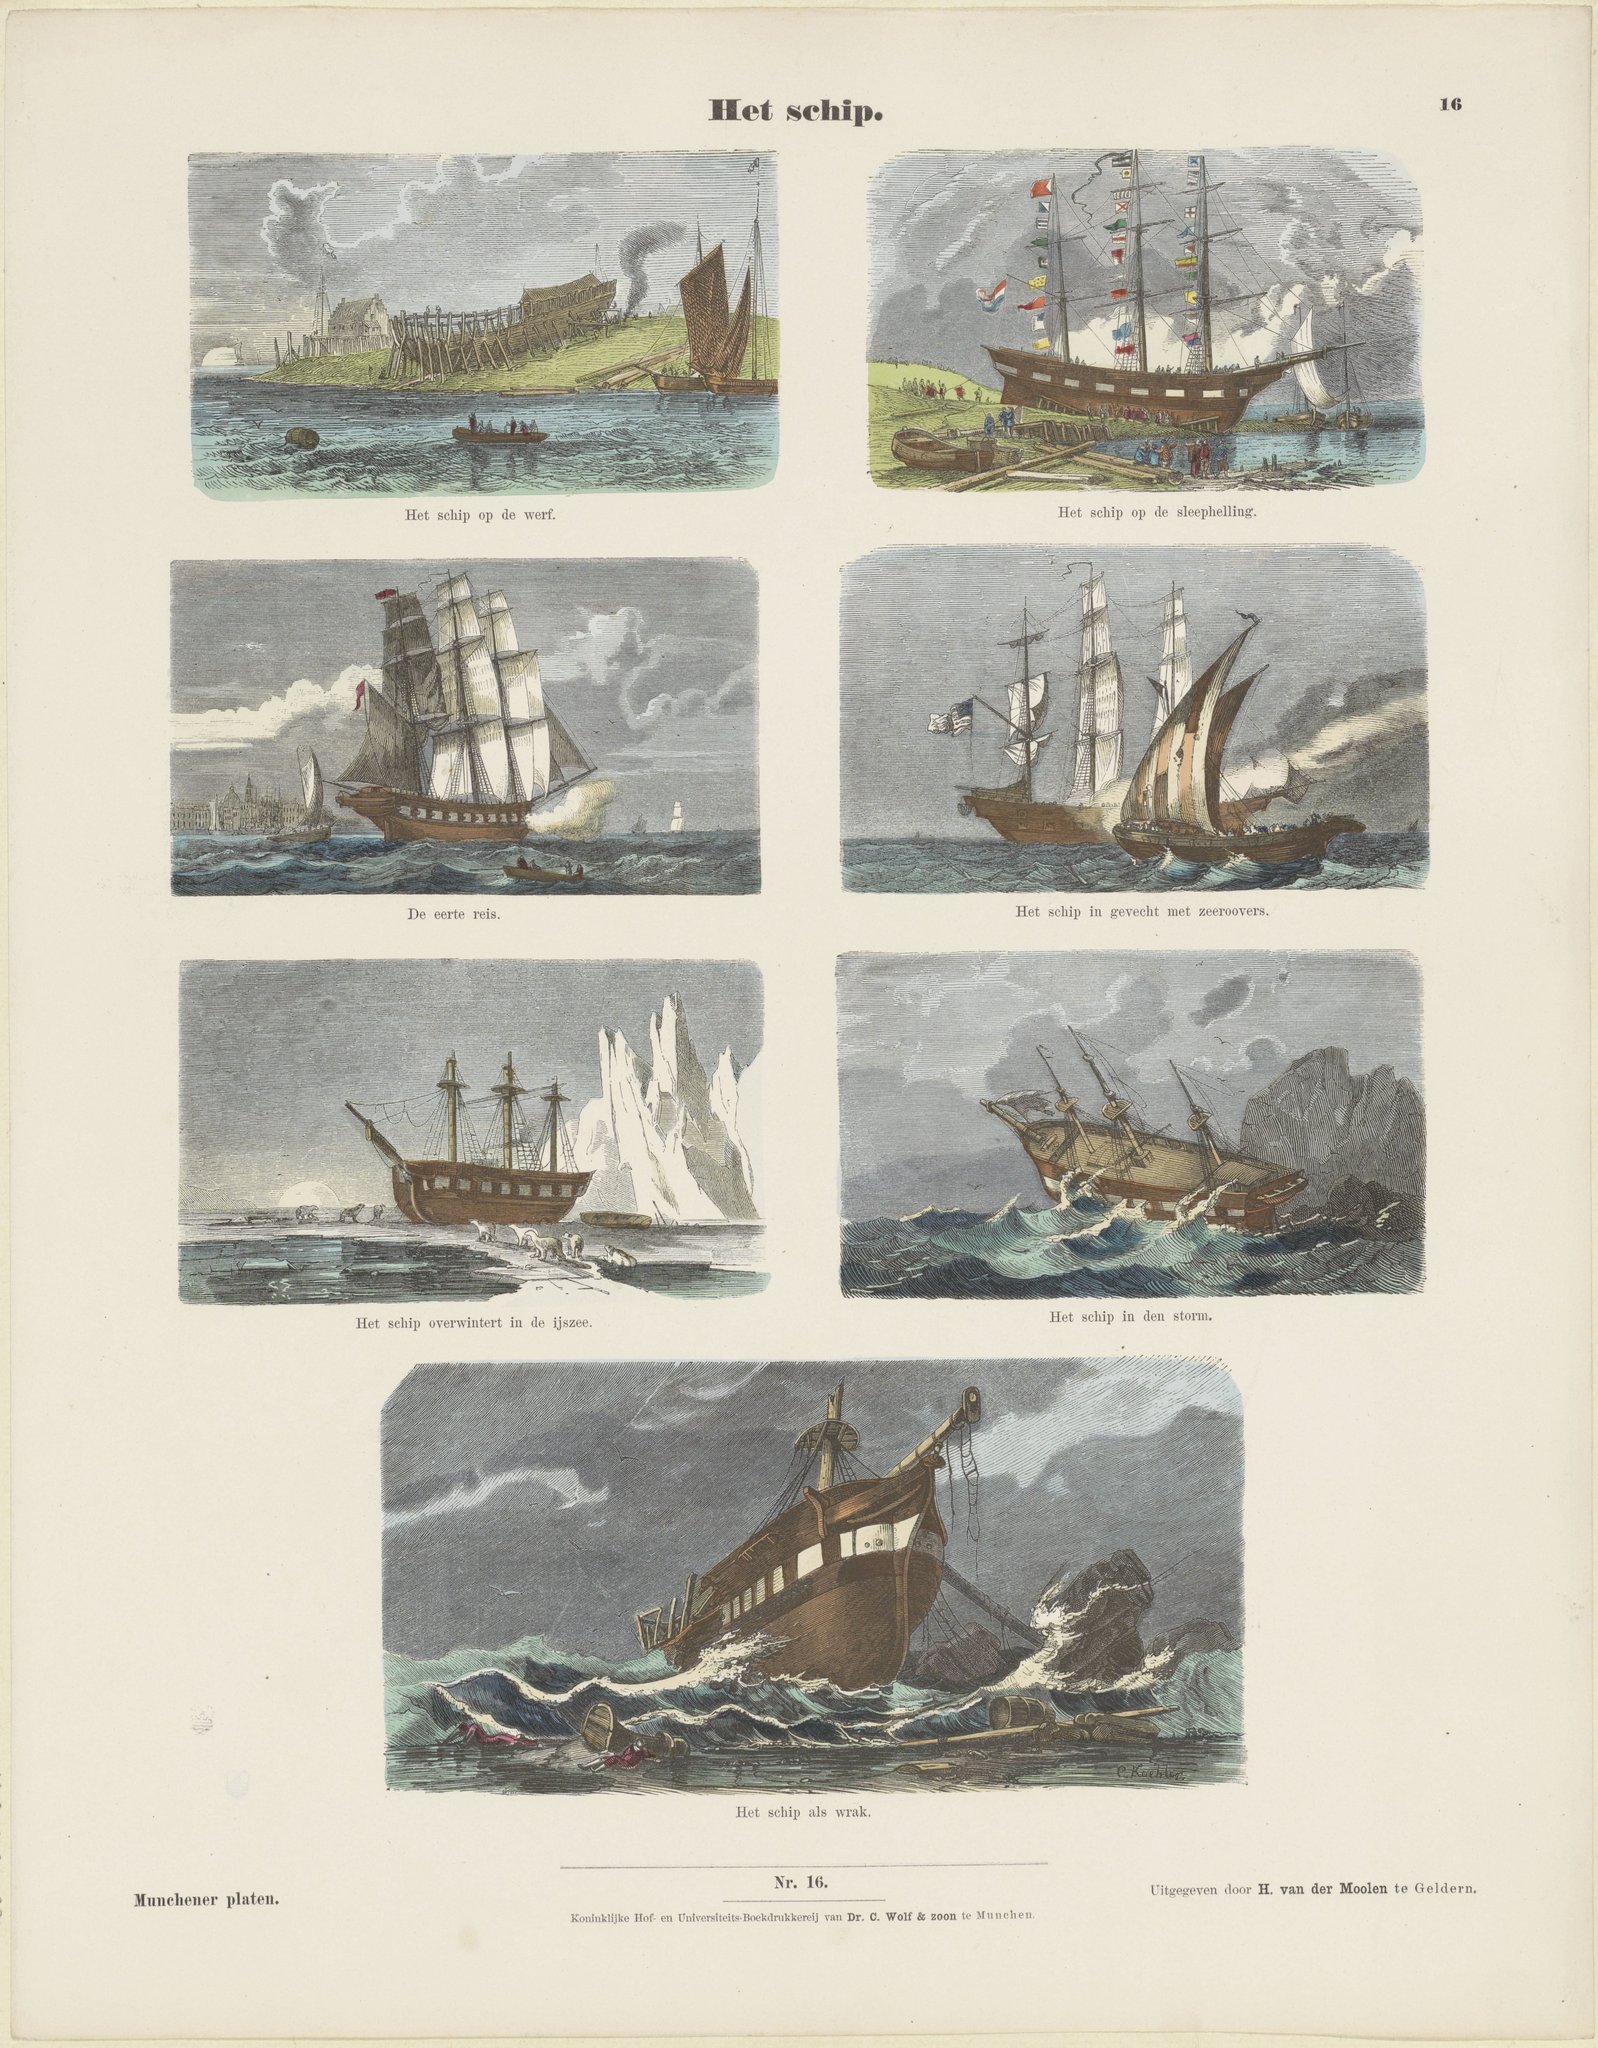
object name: print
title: Munchener platen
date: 1843-1920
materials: paper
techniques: colour, letterpress printing, engraving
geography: germany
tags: ships (in general)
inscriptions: collector's mark: Lugt 2760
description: Blad met 7 voorstellingen van schepen in verschillende situaties, waaronder op de werf, in gevecht met zeerovers en tijdens een storm op zee. Onder elke voorstelling een onderschrift. Genummerd midden onder: Nr. 16. Genummerd rechtsboven: 16.